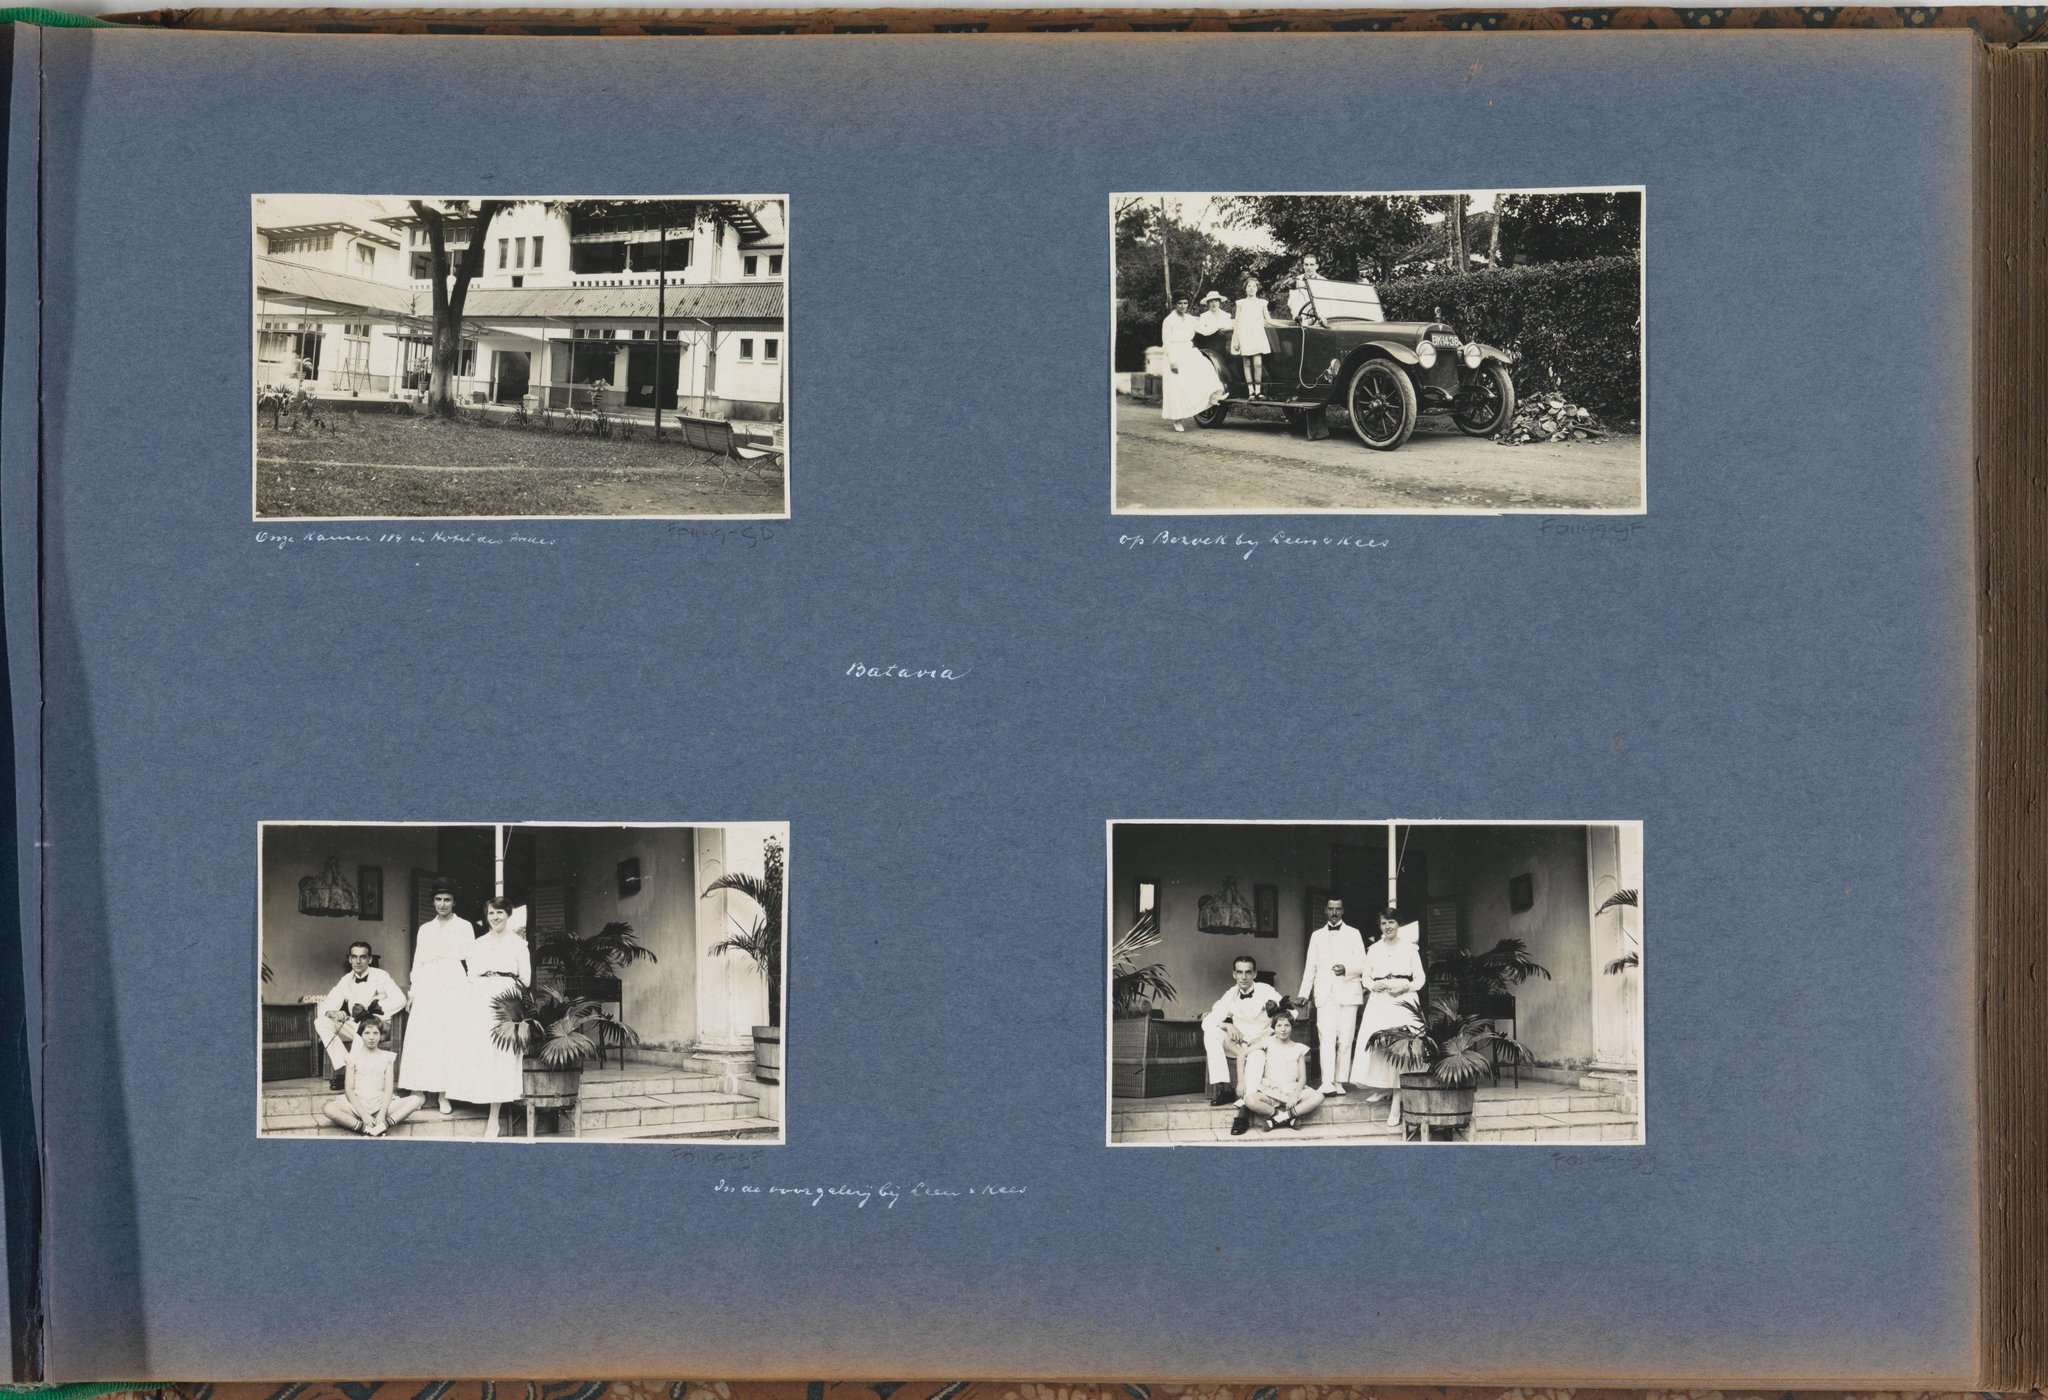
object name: album leaf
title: Twee mannen, een vrouw en een meisje poserend bij een veranda in Batavia, twee van hen aangeduid als 'Leen en Kees'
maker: Anonymous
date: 1900-1920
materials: paper, photographic support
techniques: gelatin silver print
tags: family life, loggia, verandah, porch, batavia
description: Onderdeel van reisalbum met foto's van bedrijvigheid en bezienswaardigheden op Sumatra en Java en van de reis naar en van Nederlands-Indië.